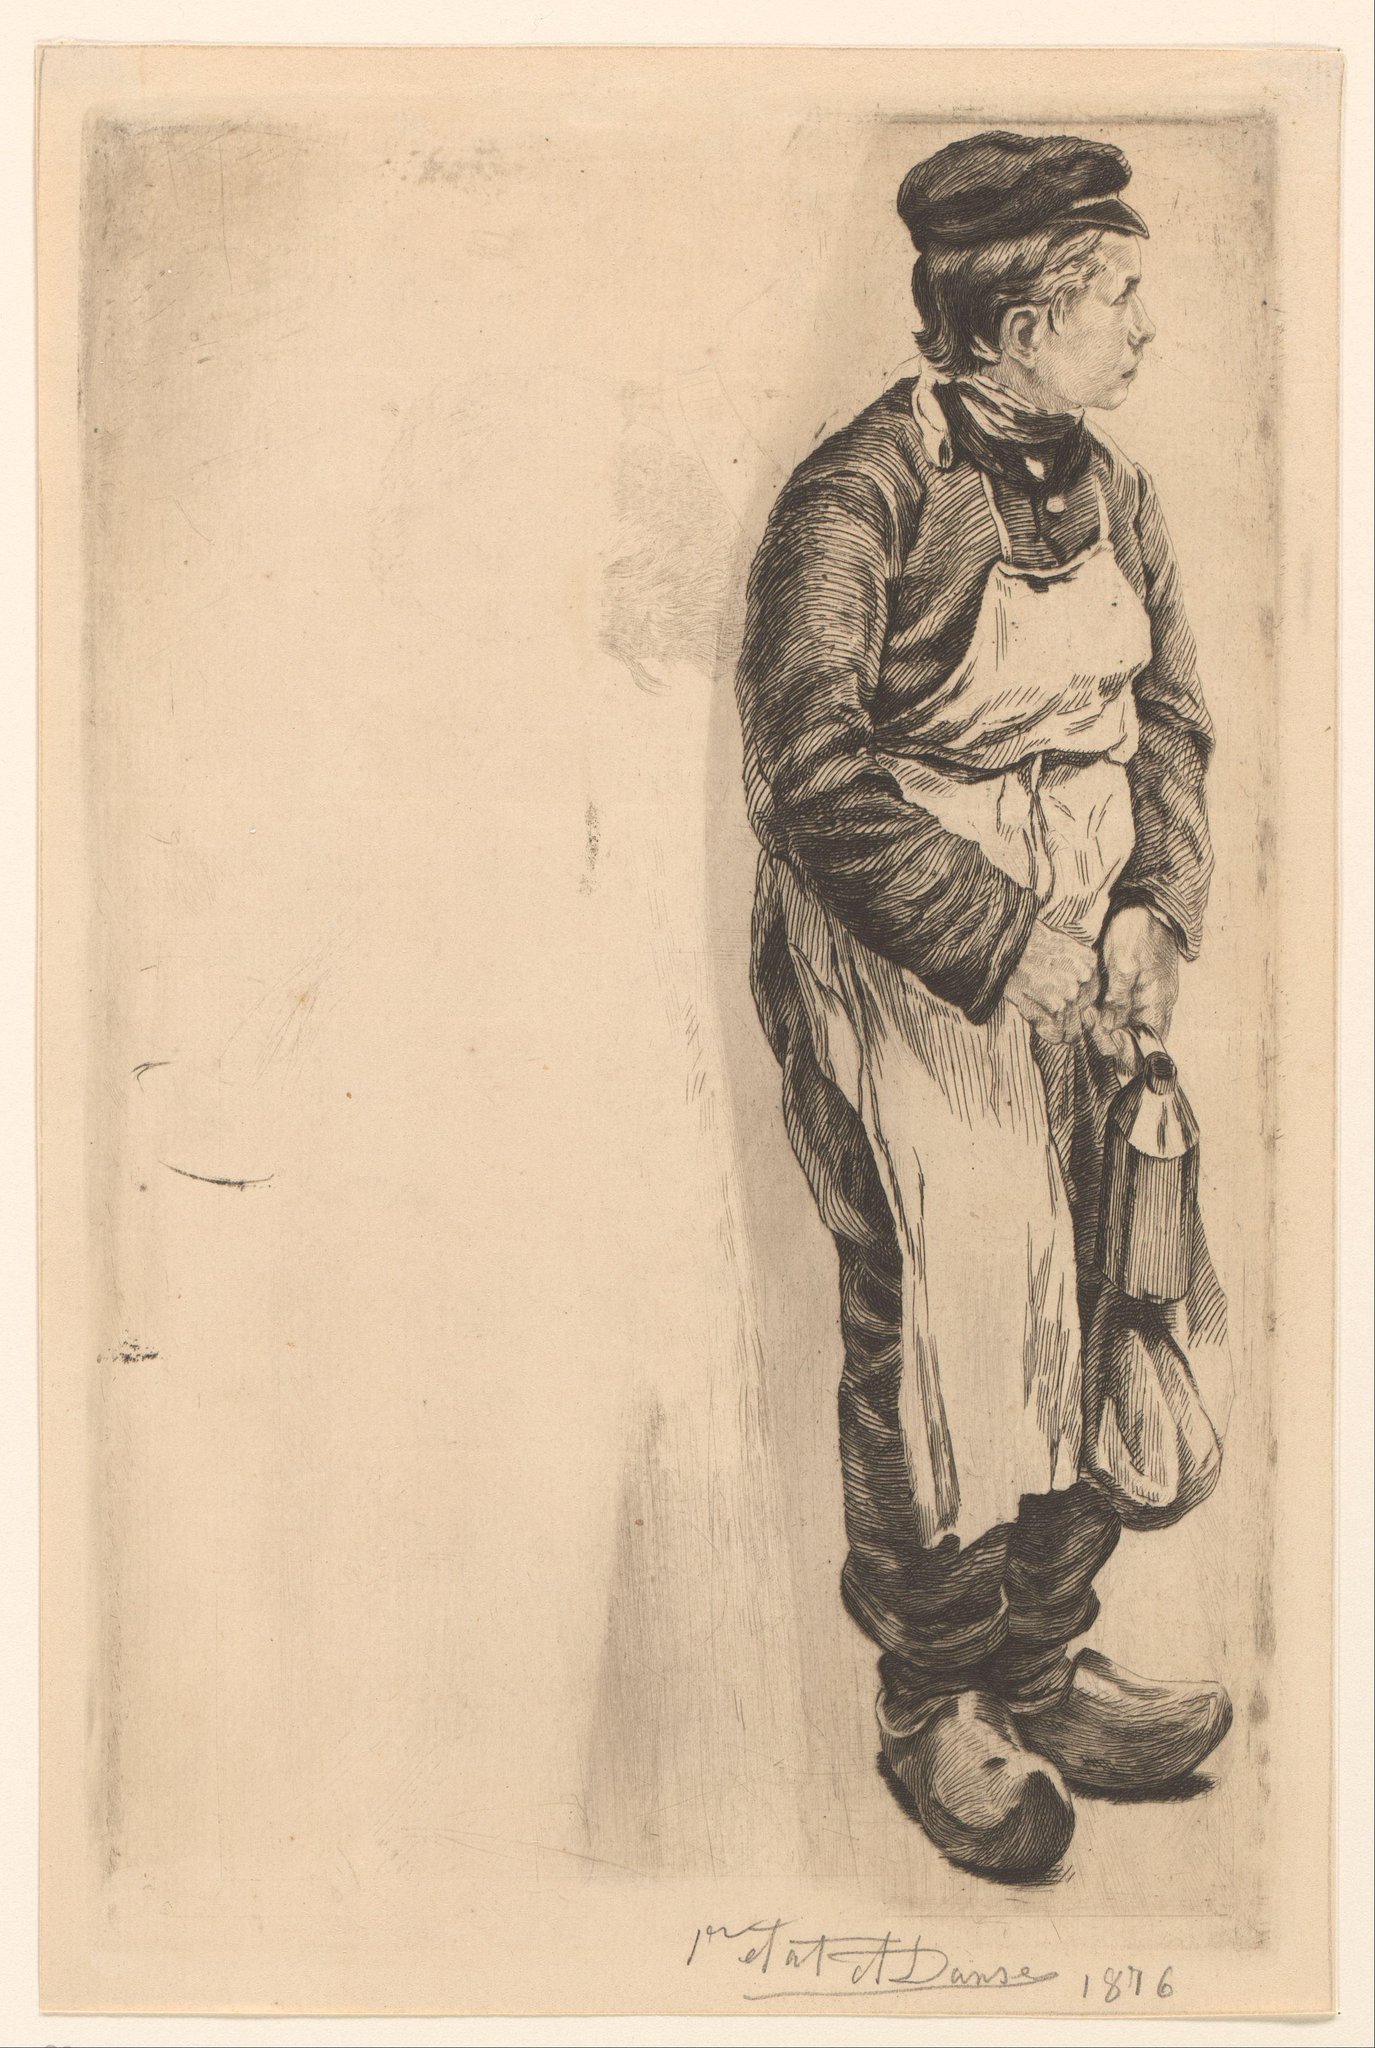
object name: print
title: Jonge arbeider op klompen, met een schort voor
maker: auguste danse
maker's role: print maker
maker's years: 1829-1929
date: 1876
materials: paper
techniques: drypoint, etching, intaglio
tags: labourers going to work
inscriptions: collector's mark: Lugt 2228, annotation: ‘1er etat’